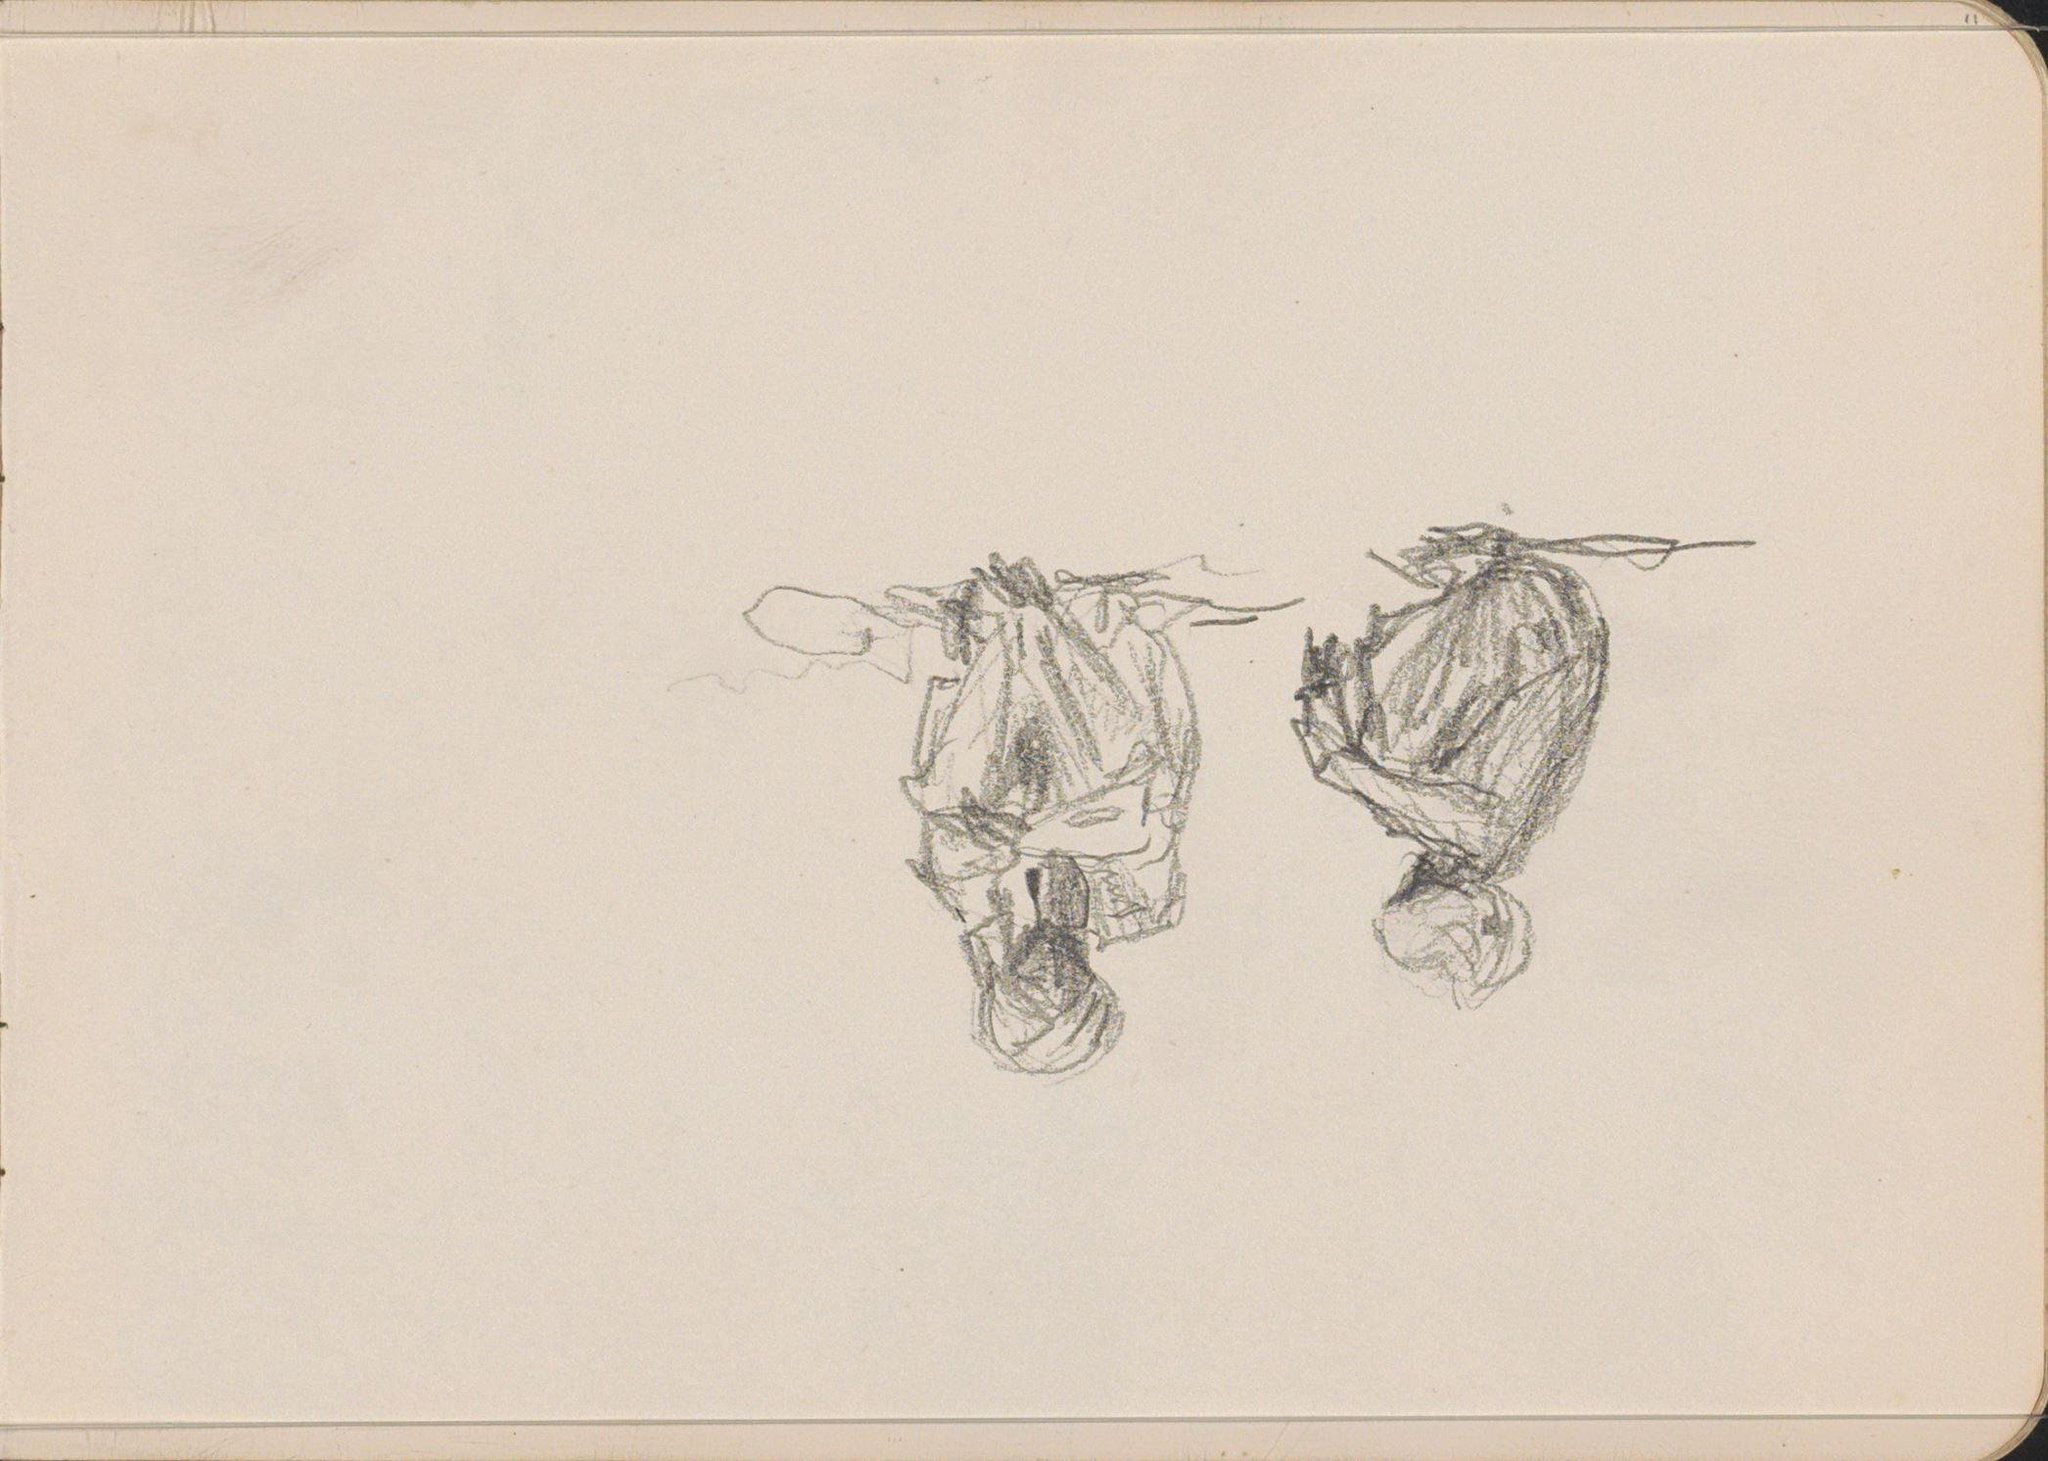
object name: sketchbook leaf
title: Twee zittende Indiase mannen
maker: marius bauer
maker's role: draughtsman, print maker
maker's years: 1867-1932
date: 1925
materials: paper, pencil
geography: india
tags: sitting figure, head-gear: turban, asiatic races and peoples: indians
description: De mannen dragen tulbanden. Pagina 11 uit een schetsboek met 15 bladen.